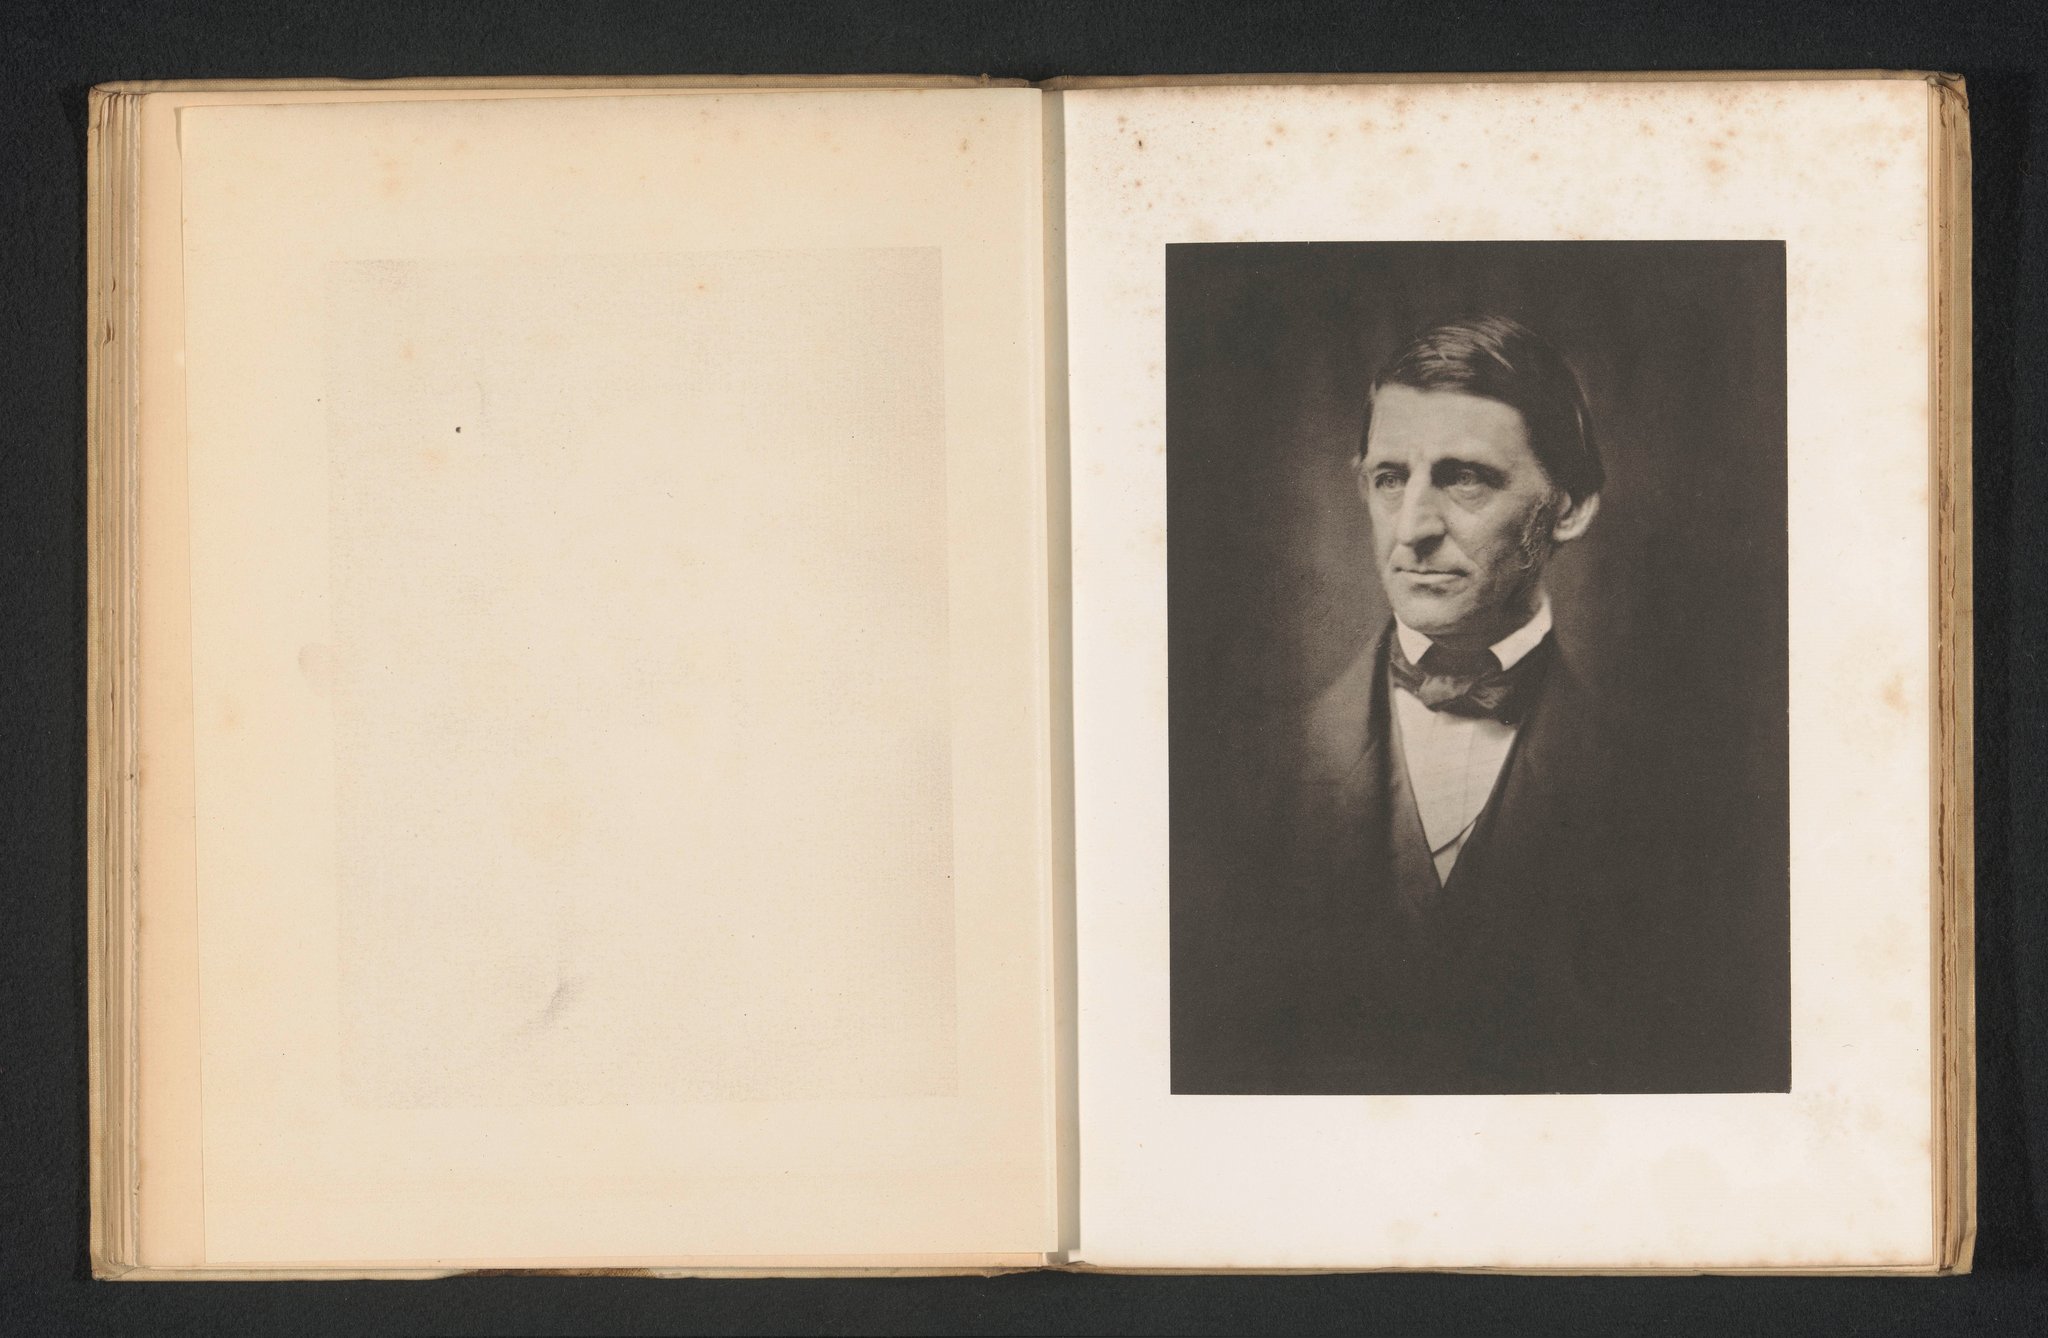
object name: photomechanical print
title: Portret van Ralph Waldo Emerson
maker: Anonymous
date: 1877-1882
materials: paper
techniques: photograph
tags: historical persons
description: Prent op vierde ongenummerde pagina na pagina 27.